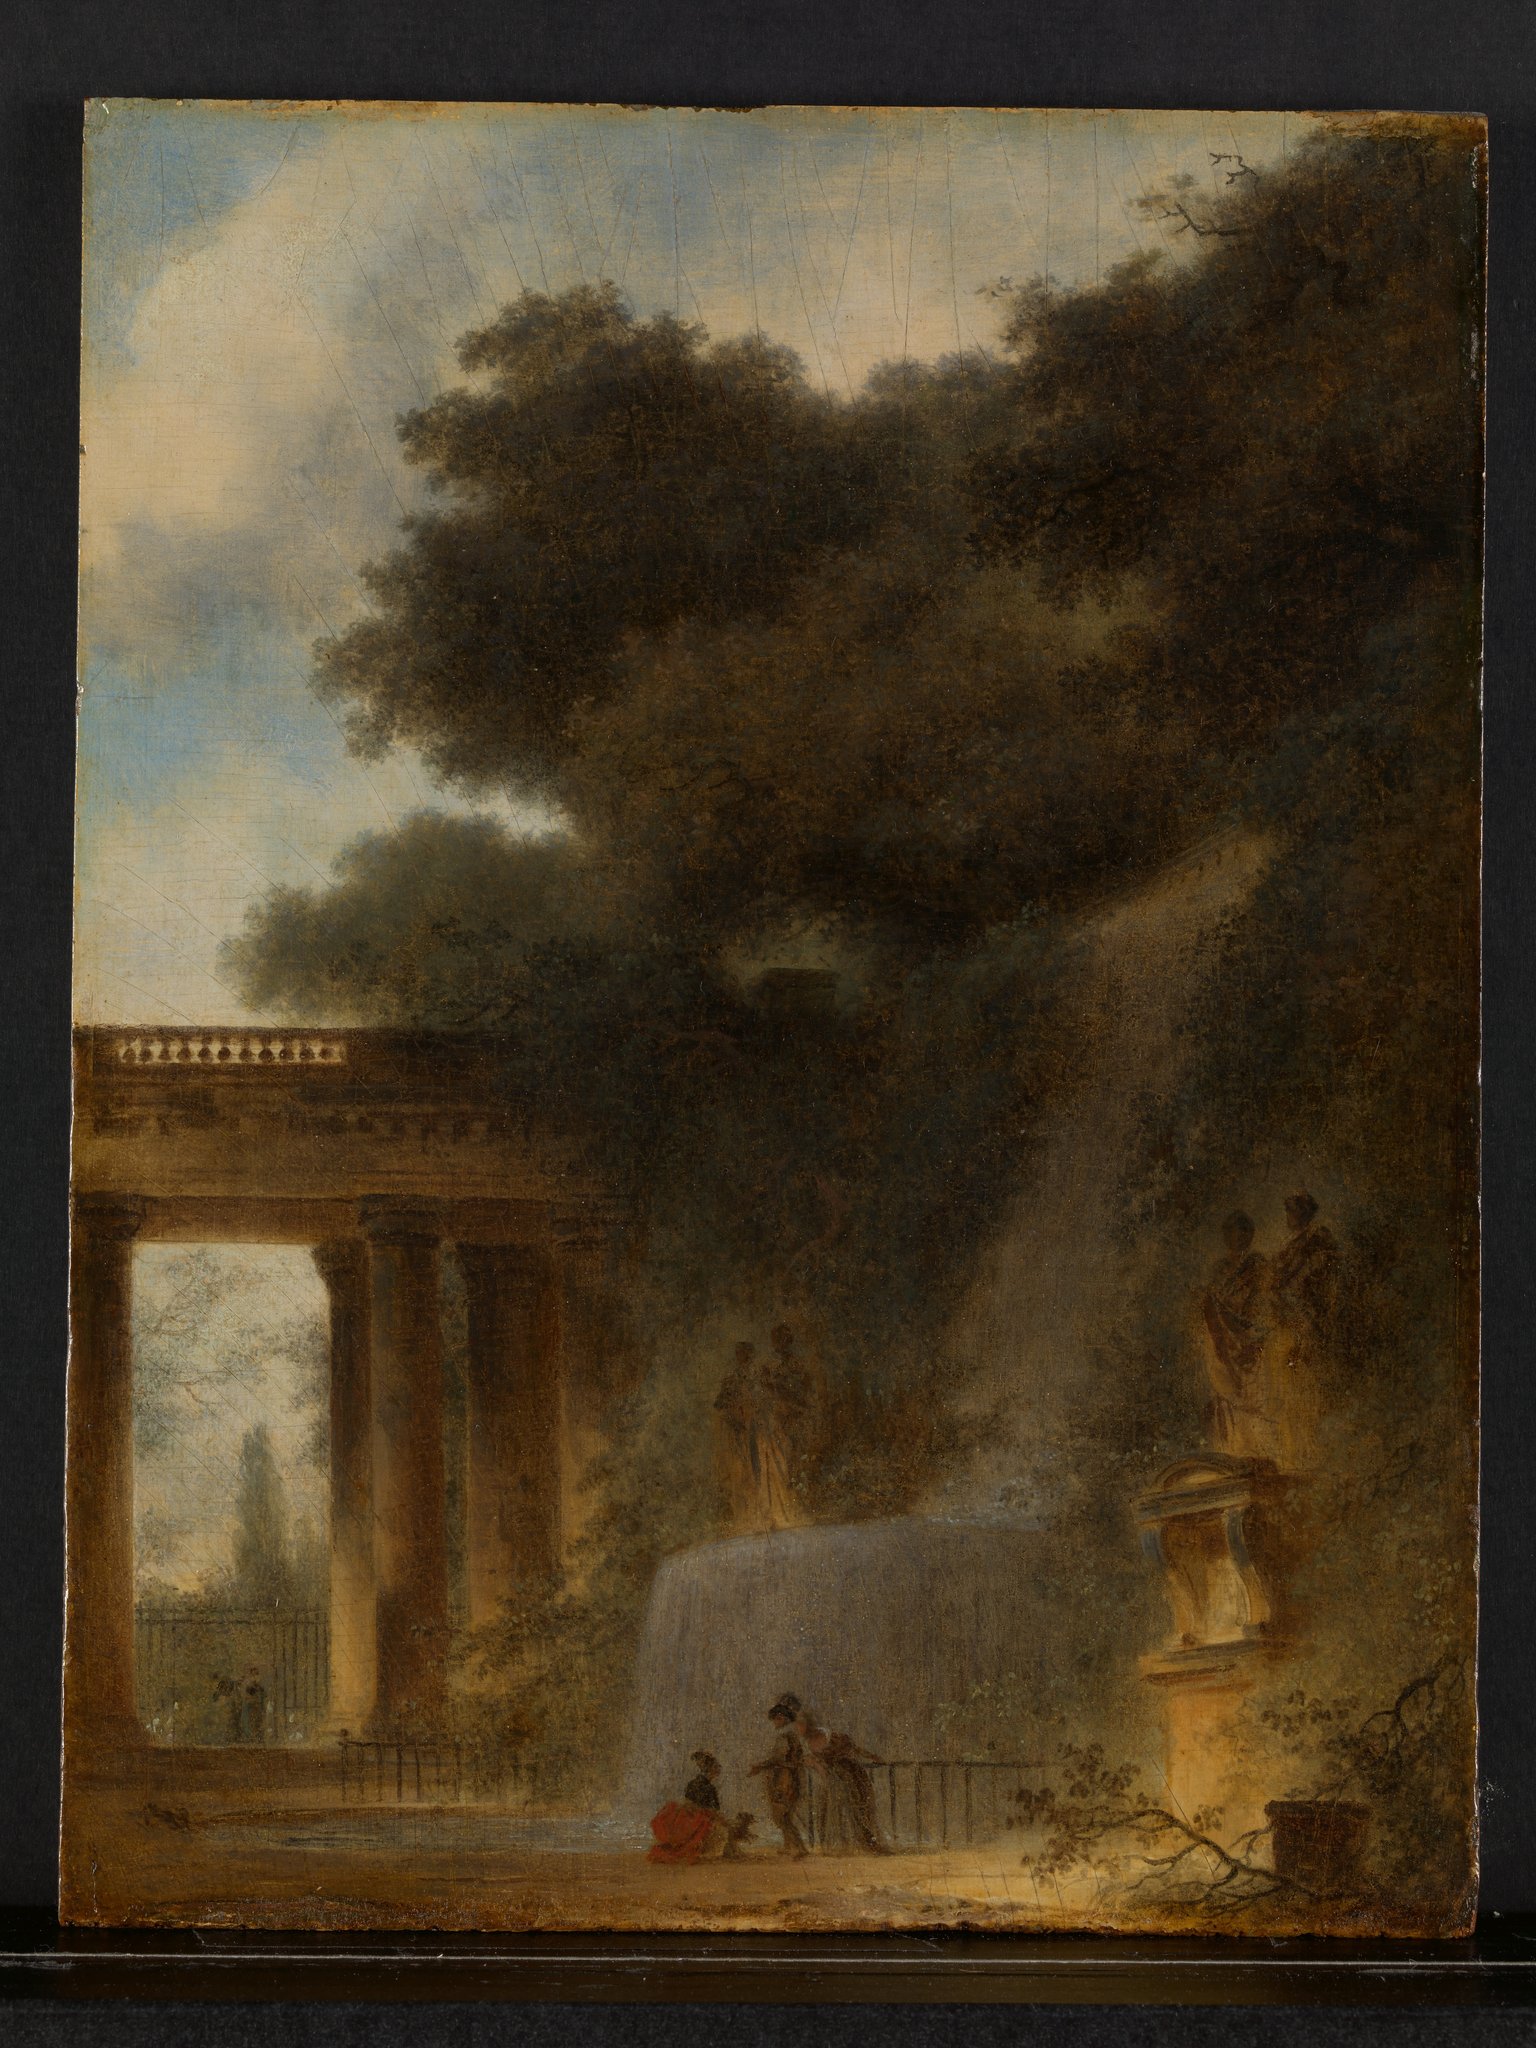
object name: painting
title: The Cascade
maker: jean honoré fragonard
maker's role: artist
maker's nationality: french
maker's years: 1732-1806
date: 1775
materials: oil, wood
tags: gardens,waterfalls